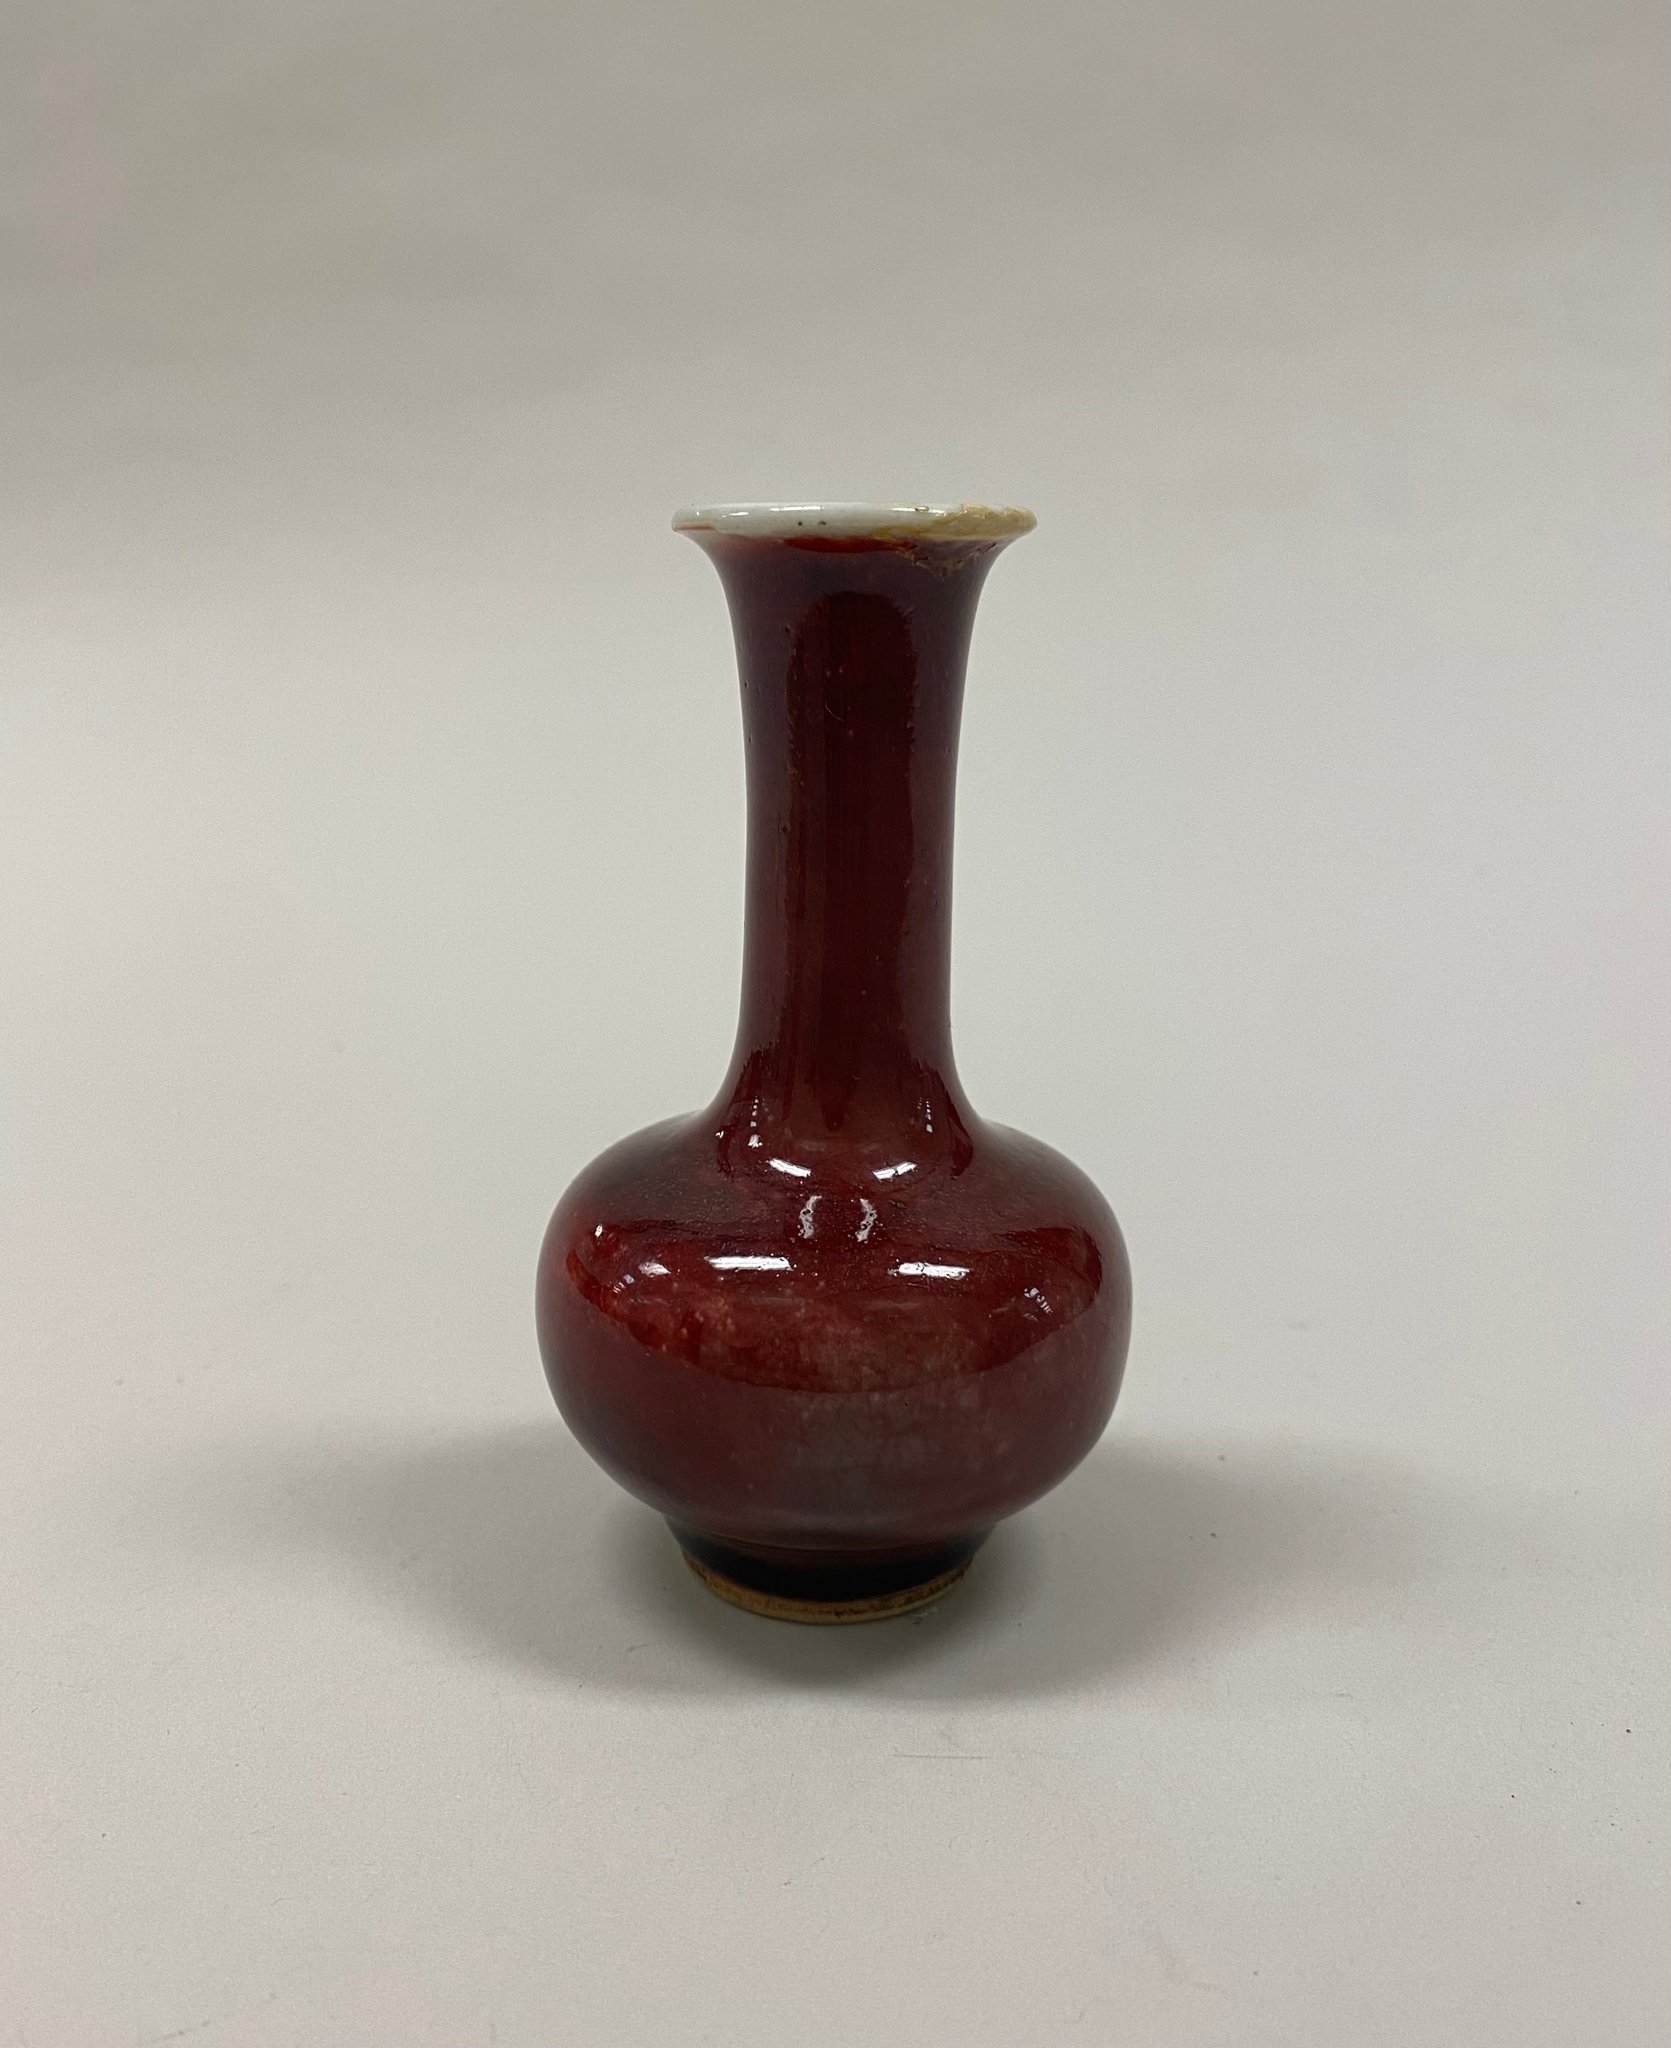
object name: vase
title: Miniature vase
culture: chinese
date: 1701-1800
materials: copper, glaze, porcelain